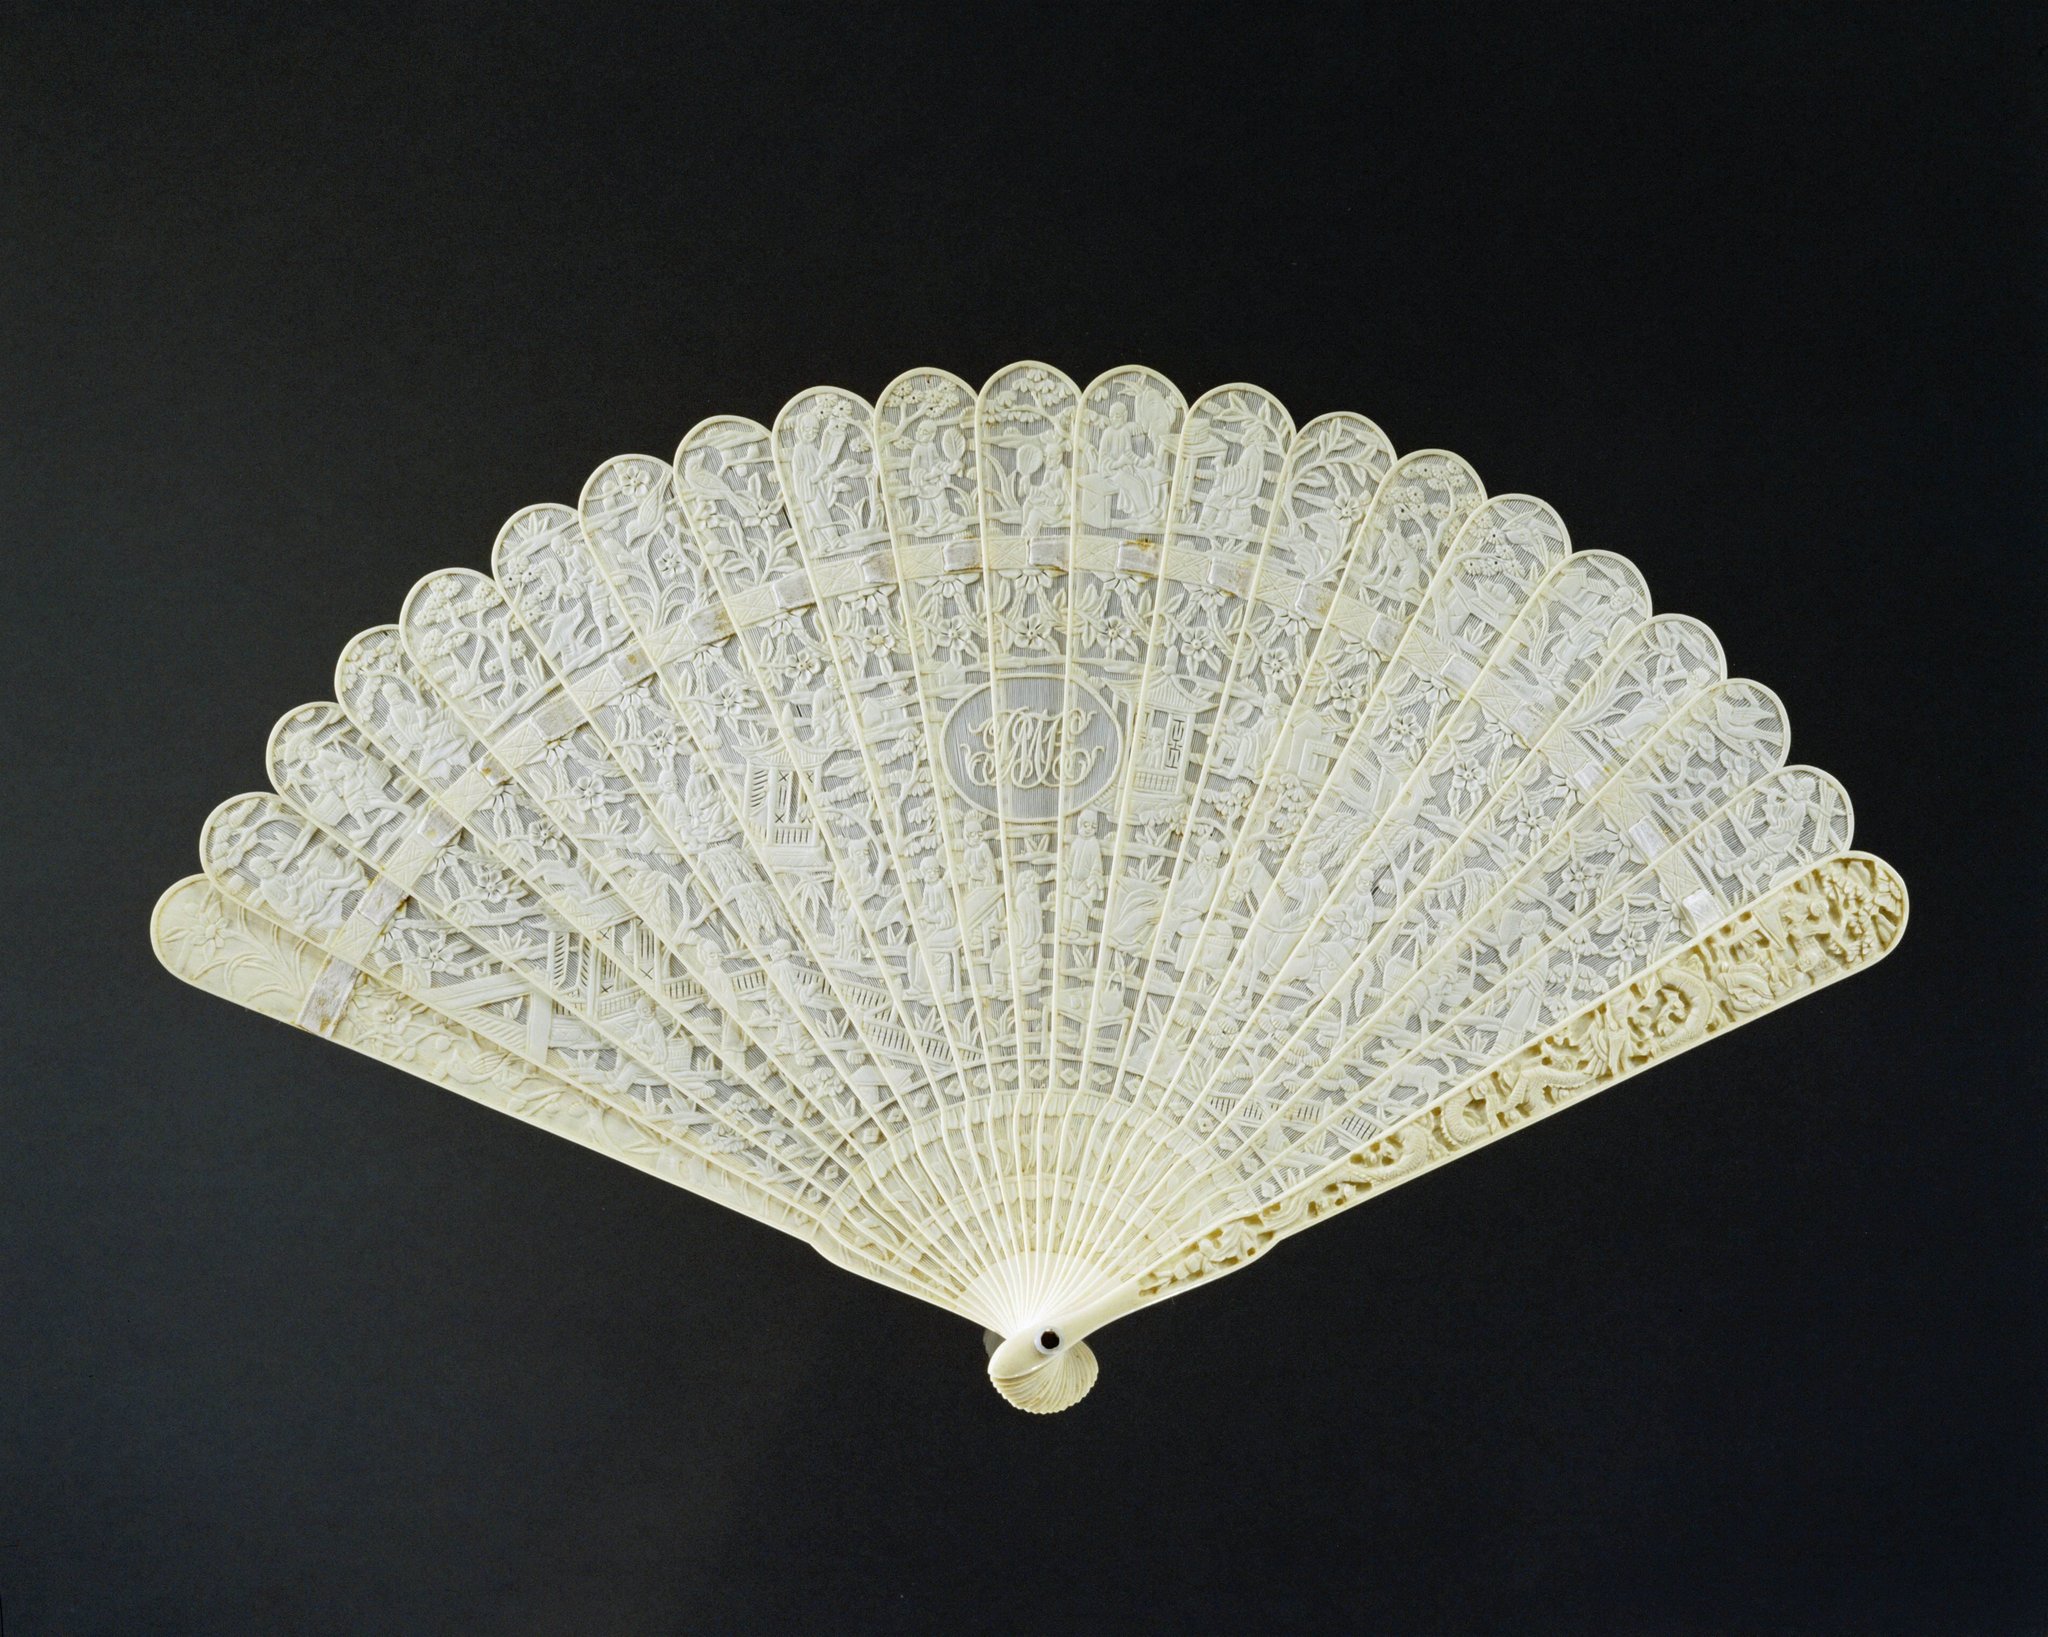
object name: brisé fan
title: Brisé-waaier van ivoor, gedritst gesneden, aan beide zijden Chinese taferelen in reliëf, centraal in het midden een monogram met PMH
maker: Anonymous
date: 1830-1840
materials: copper, ivory, mother of pearl, textile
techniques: cutting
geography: guangdong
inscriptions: monogram: ‘PMH’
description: Brisé-waaier van ivoor, gedritst gesneden, aan beide zijden Chinese taferelen in reliëf gesneden, centraal in het midden een monogram met PMH. De 21 aaneengesloten benen in reliëf worden door een satijnen lint bijeengehouden. De beide buitenbenen met draak in relief gesneden. Parelmoeren schijfje bij sluitpin.